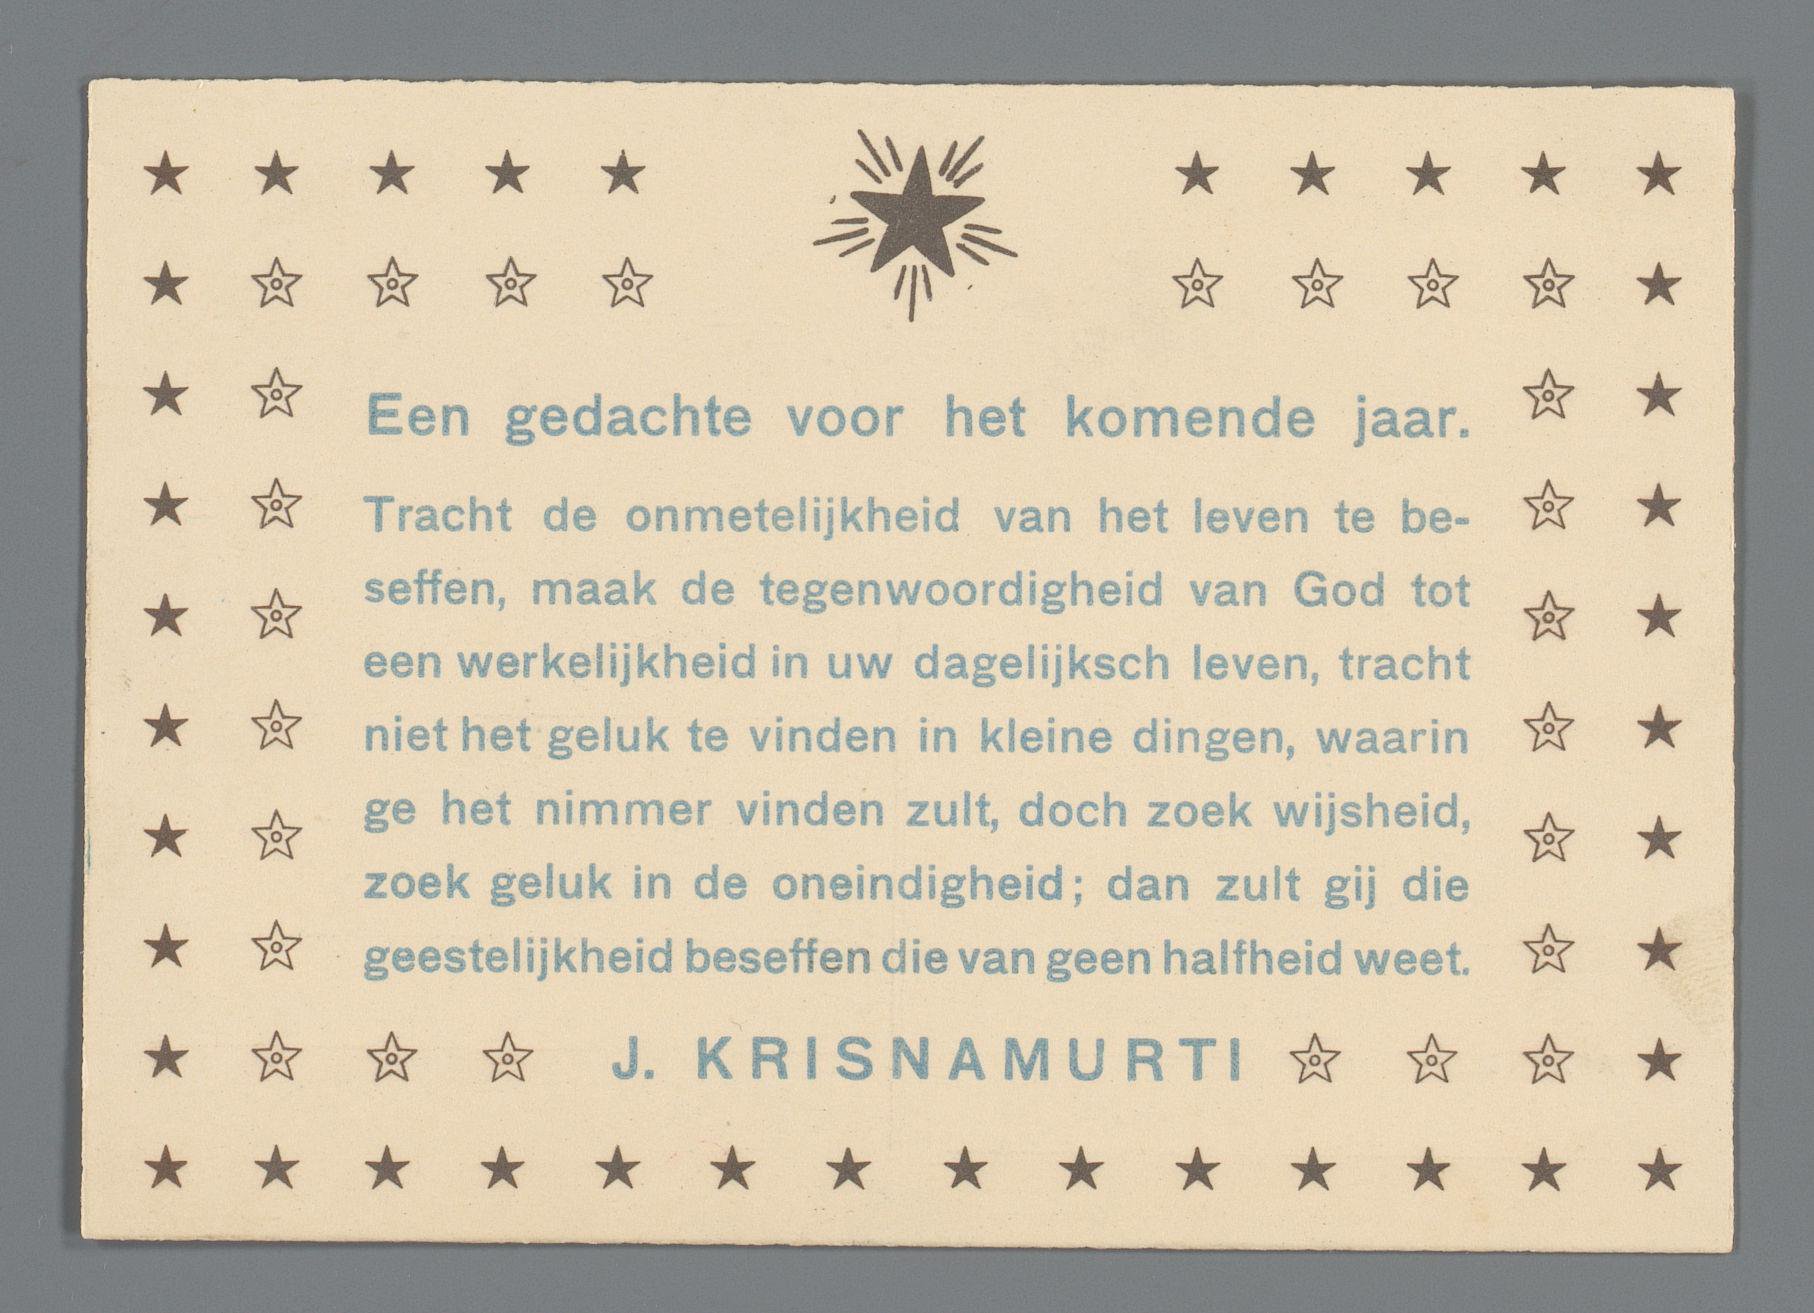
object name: print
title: Briefkaart met als nieuwjaarsgroet een citaat van Krishnamurti, omlijst met styerren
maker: mathieu lauweriks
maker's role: designer, draughtsman, print maker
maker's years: 1864-1932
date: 1900-1932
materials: paper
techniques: printing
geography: amsterdam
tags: miscellaneous religions, cults and doctrines: theosophy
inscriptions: collector's mark: Lugt 2228